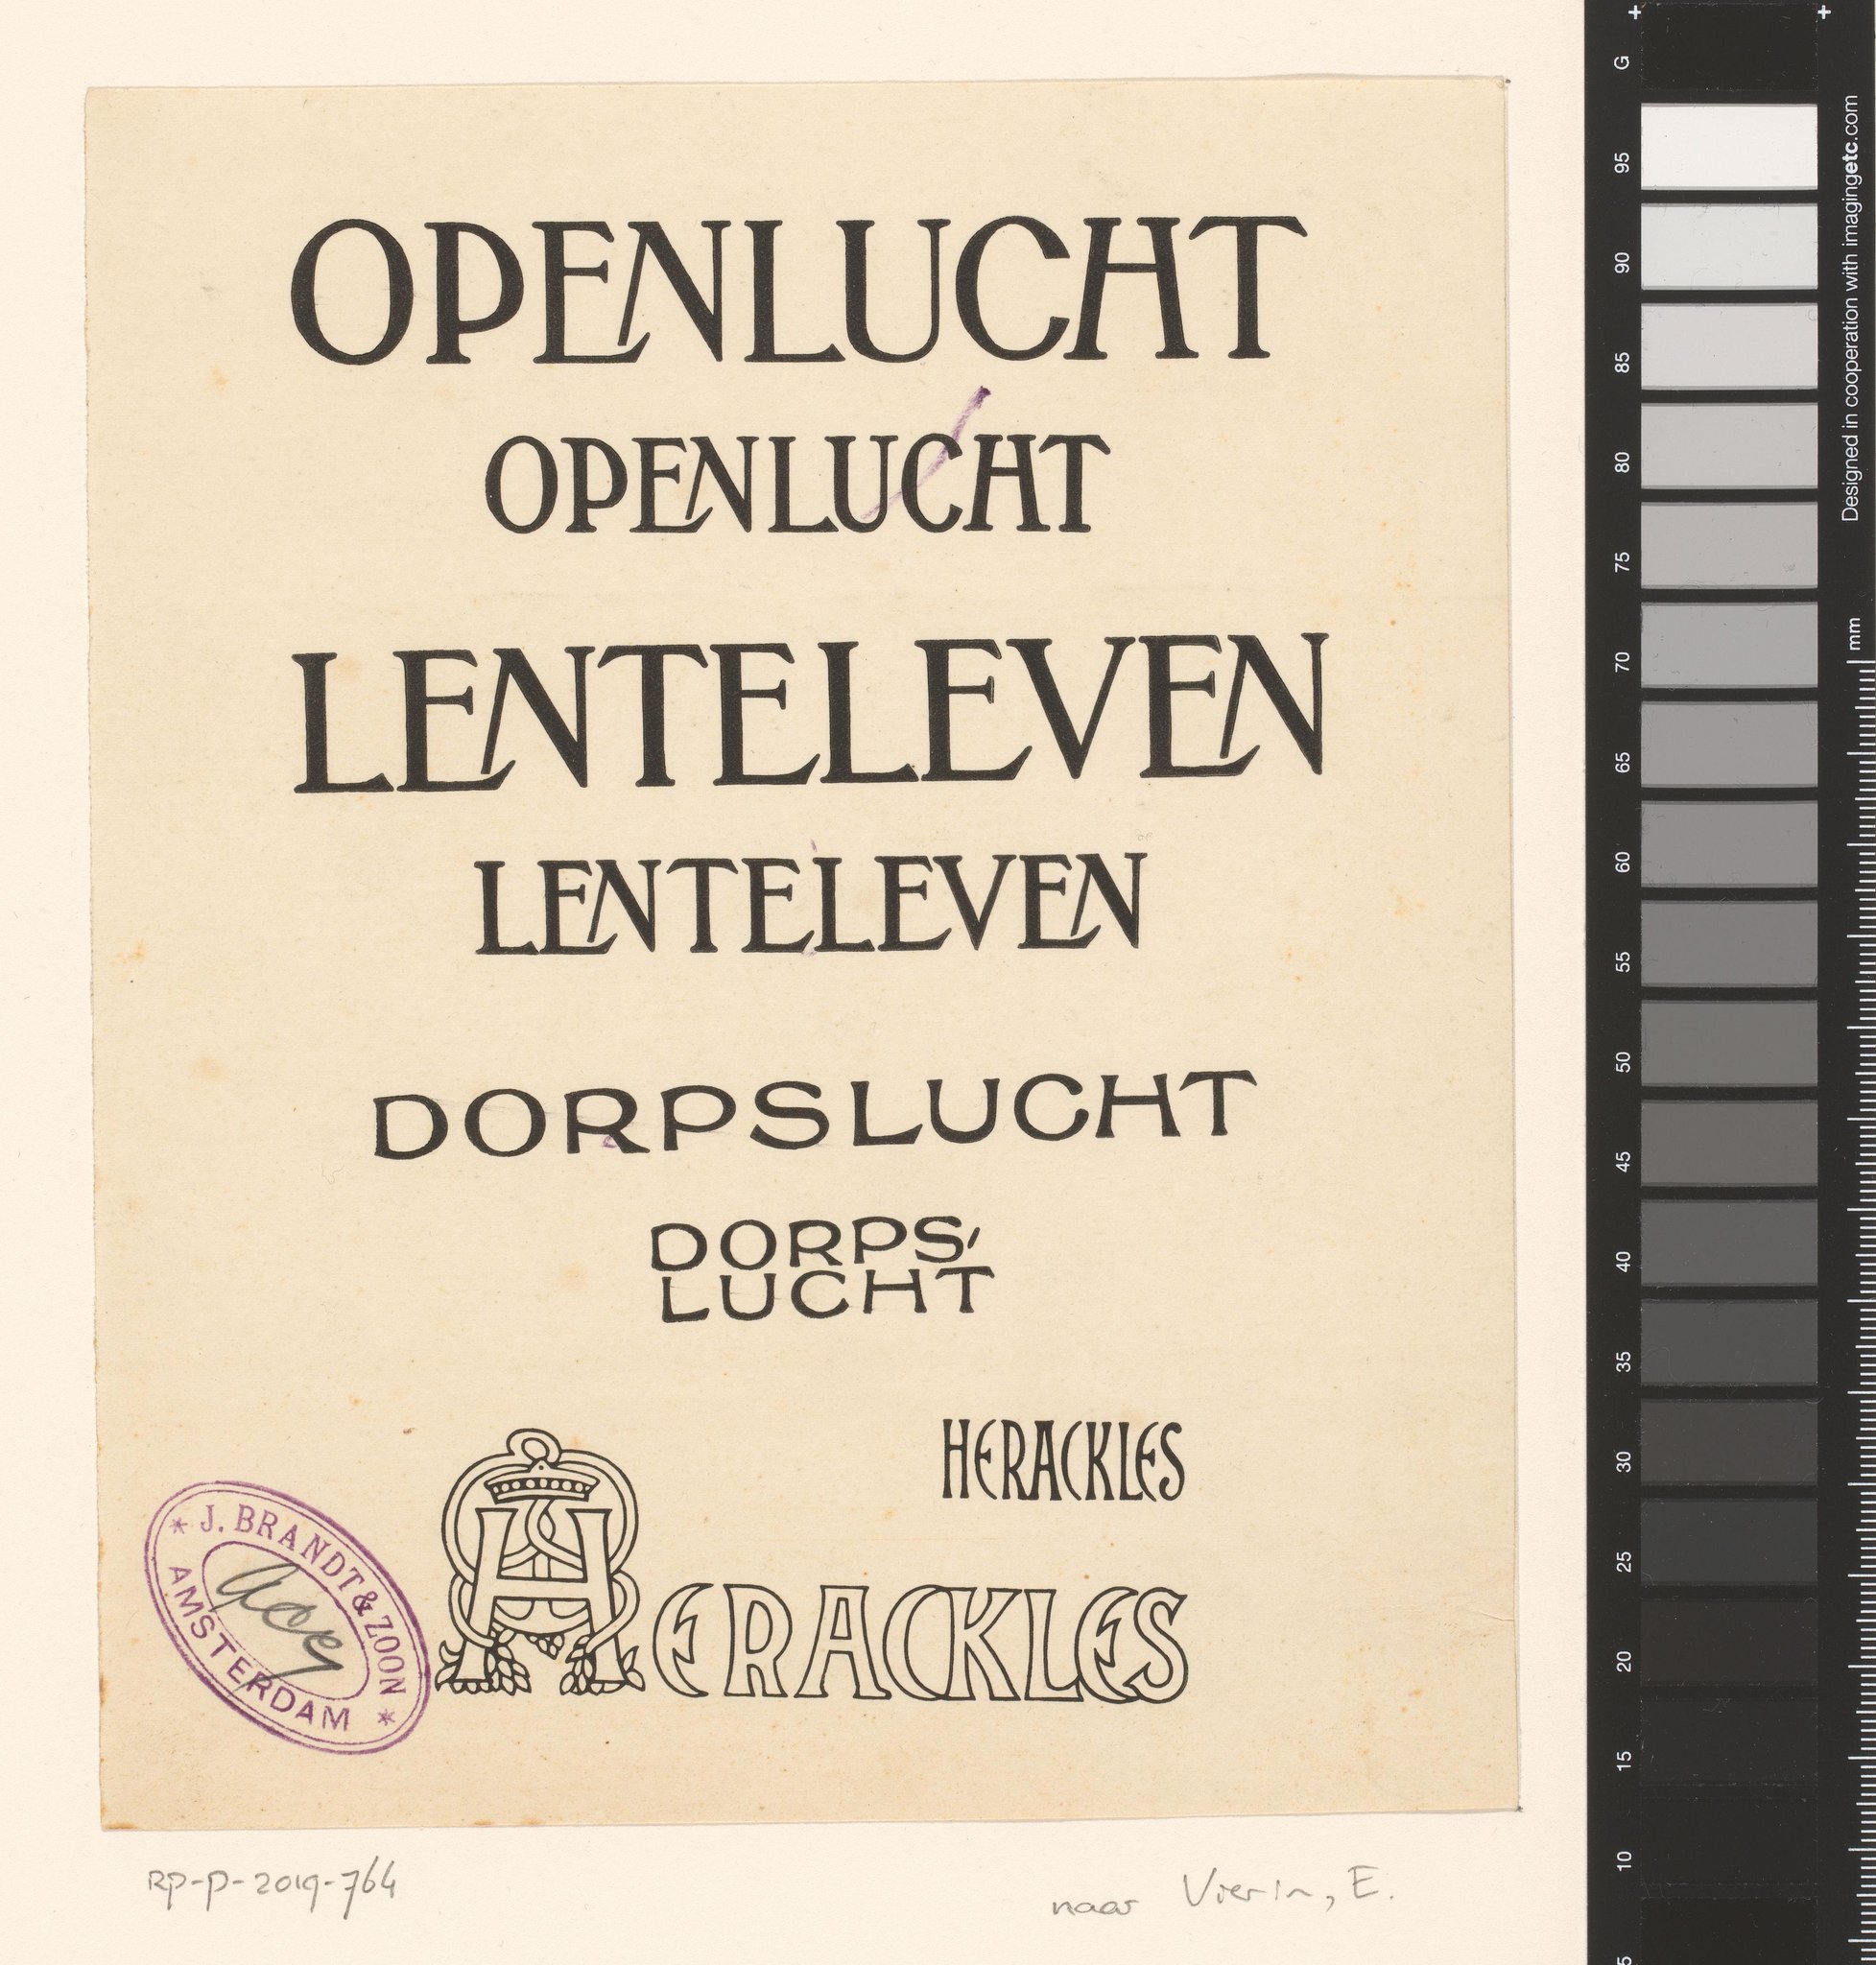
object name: photomechanical print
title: Letterontwerpen voor drie romans van Stijn Streuvels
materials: paper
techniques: printing block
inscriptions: stamp: ‘*J. BRANDT & ZOON*/ AMSTERDAM’, collector's mark: Lugt 2228a, number:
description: Letterontwerpen voor Dorpslucht (1914), Lenteleven (1900) en Open lucht (1905).